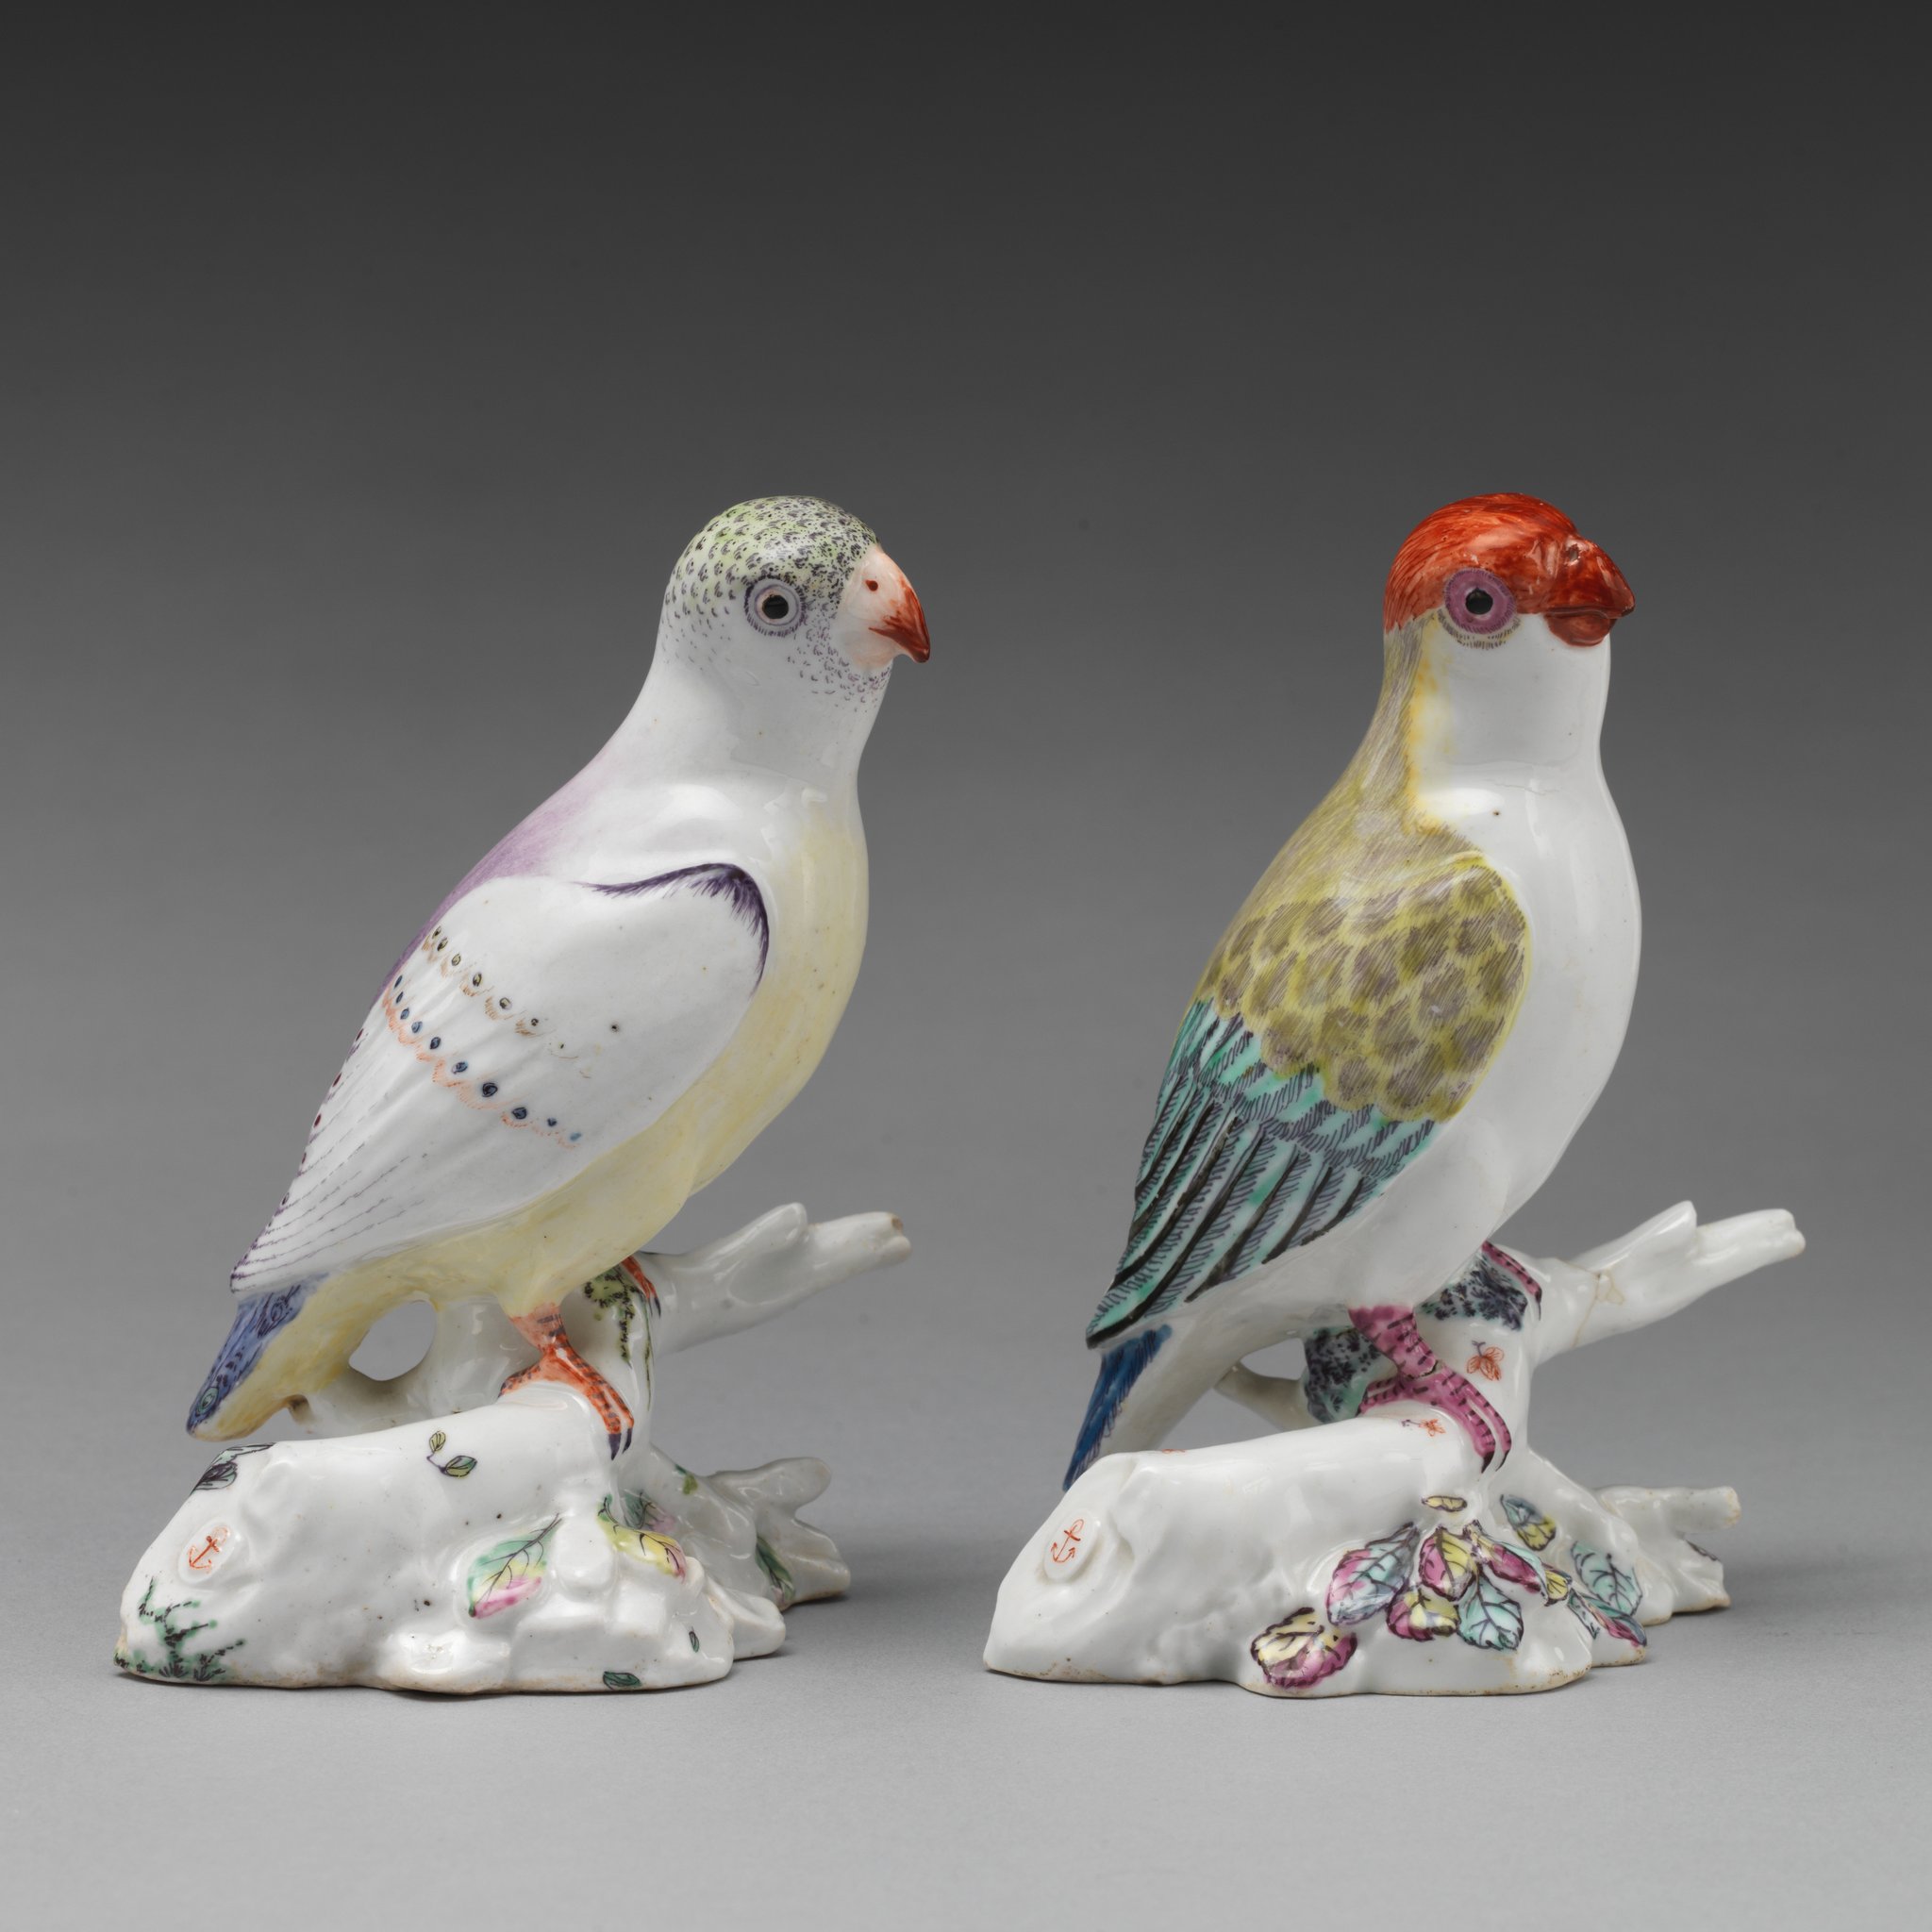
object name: figure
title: Pair of parakeets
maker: chelsea porcelain manufactory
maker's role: factory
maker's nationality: british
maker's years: 1744-1784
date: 1750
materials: soft paste porcelain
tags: birds